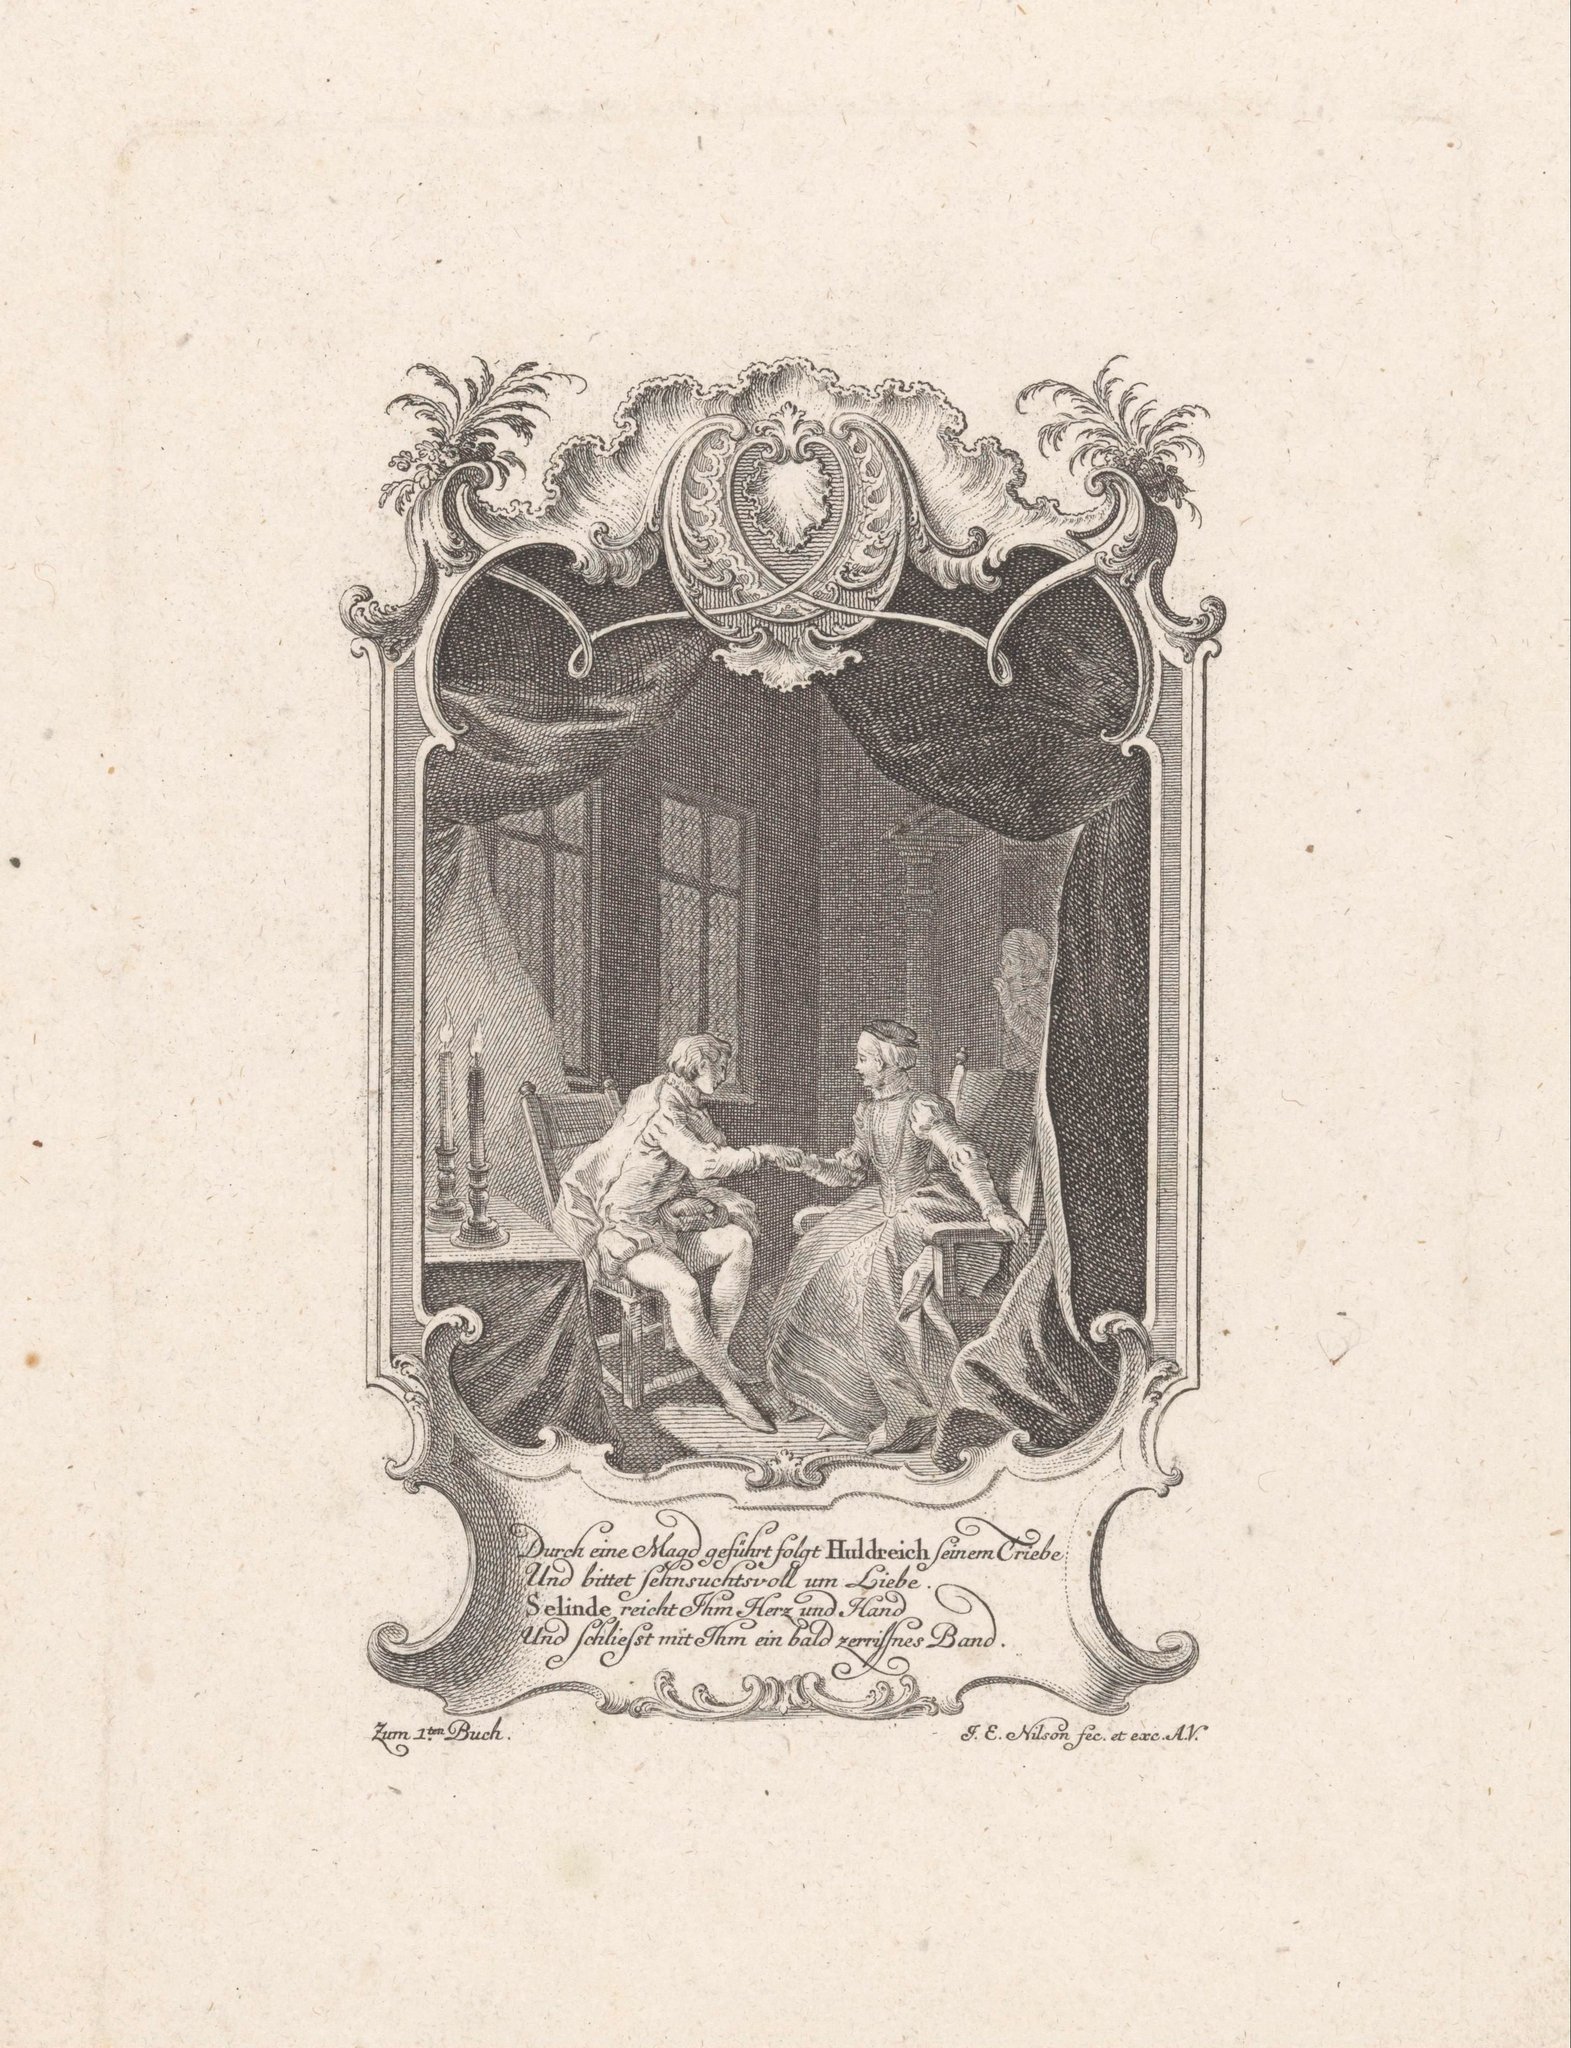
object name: ornament print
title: Selinde en Huldreich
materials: paper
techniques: engraving, etching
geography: augsburg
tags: lovers' meeting, the envious friends; criticizing bystanders ~ love couple, specific works of literature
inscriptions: collector's mark: Lugt 2760, collector's mark: Lugt 2228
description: Selinde ontvangt Huldreich in een door kaarsen verlichte kamer. Hij rijkt haar zijn hand. Rechts door een deur kijkt een oude vrouw naar de twee. Rondom de voorstelling een omraming met rocaille ornamenten en bladmotieven. In de ondermarge een vierregelige Duitse tekst.